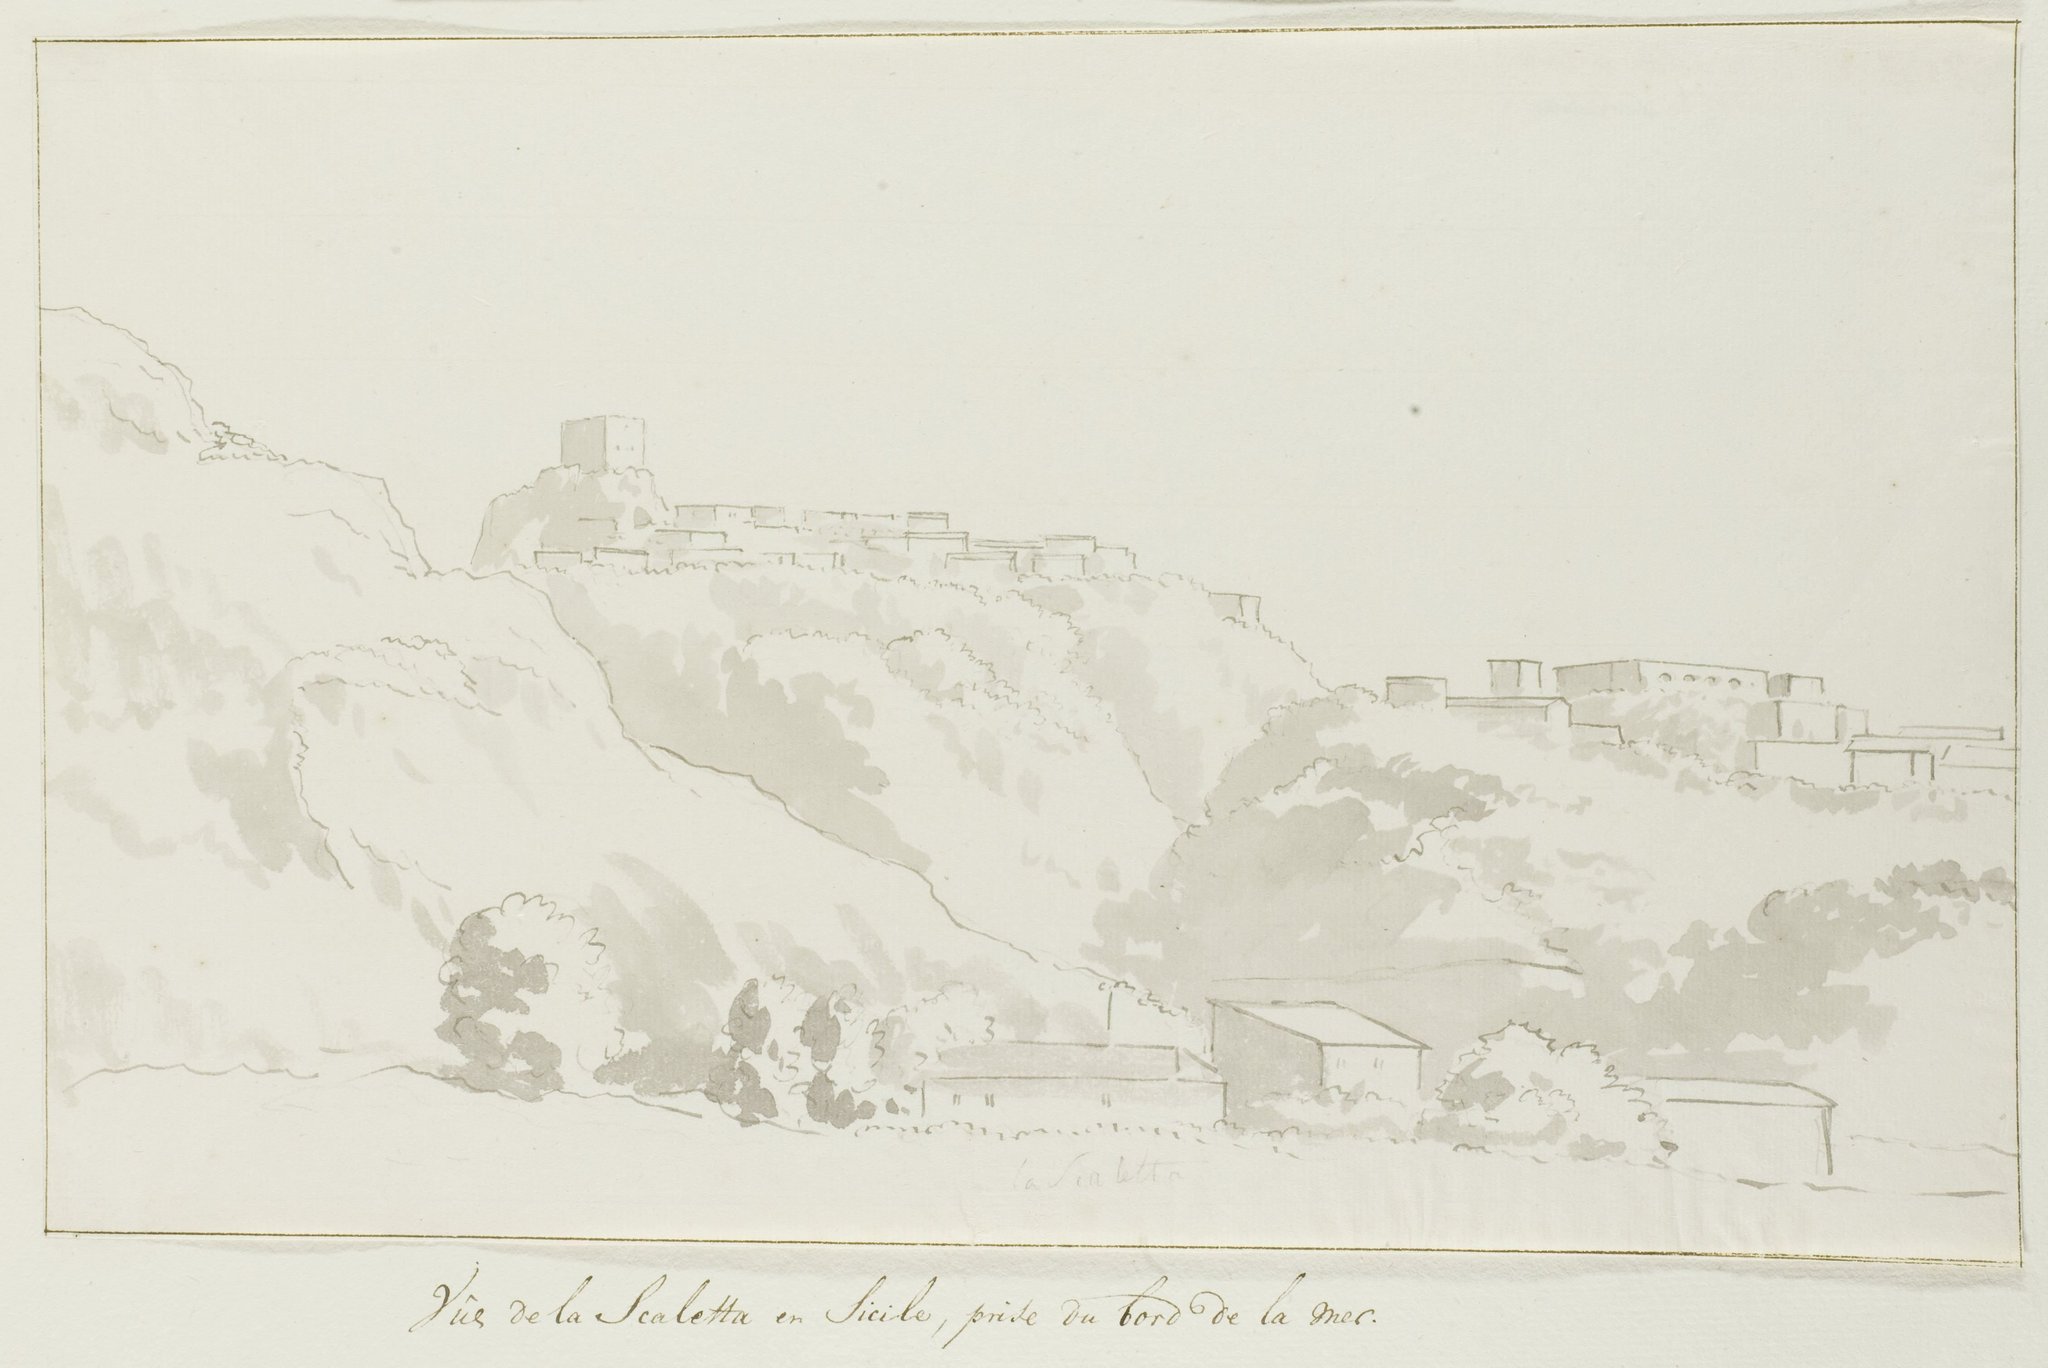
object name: drawing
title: Voyage en Italie, en Sicile et à Malte - 1778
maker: louis ducros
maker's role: draughtsman, print maker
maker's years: 1748-1810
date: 1778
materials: chalk, paper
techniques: brush, pen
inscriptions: inscription: ‘No 148 Vue de la Scaletta en Sicile, prise du bord de la mer’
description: Tekening uit het album 'Voyage en Italie, en Sicile et à Malte', 1778.